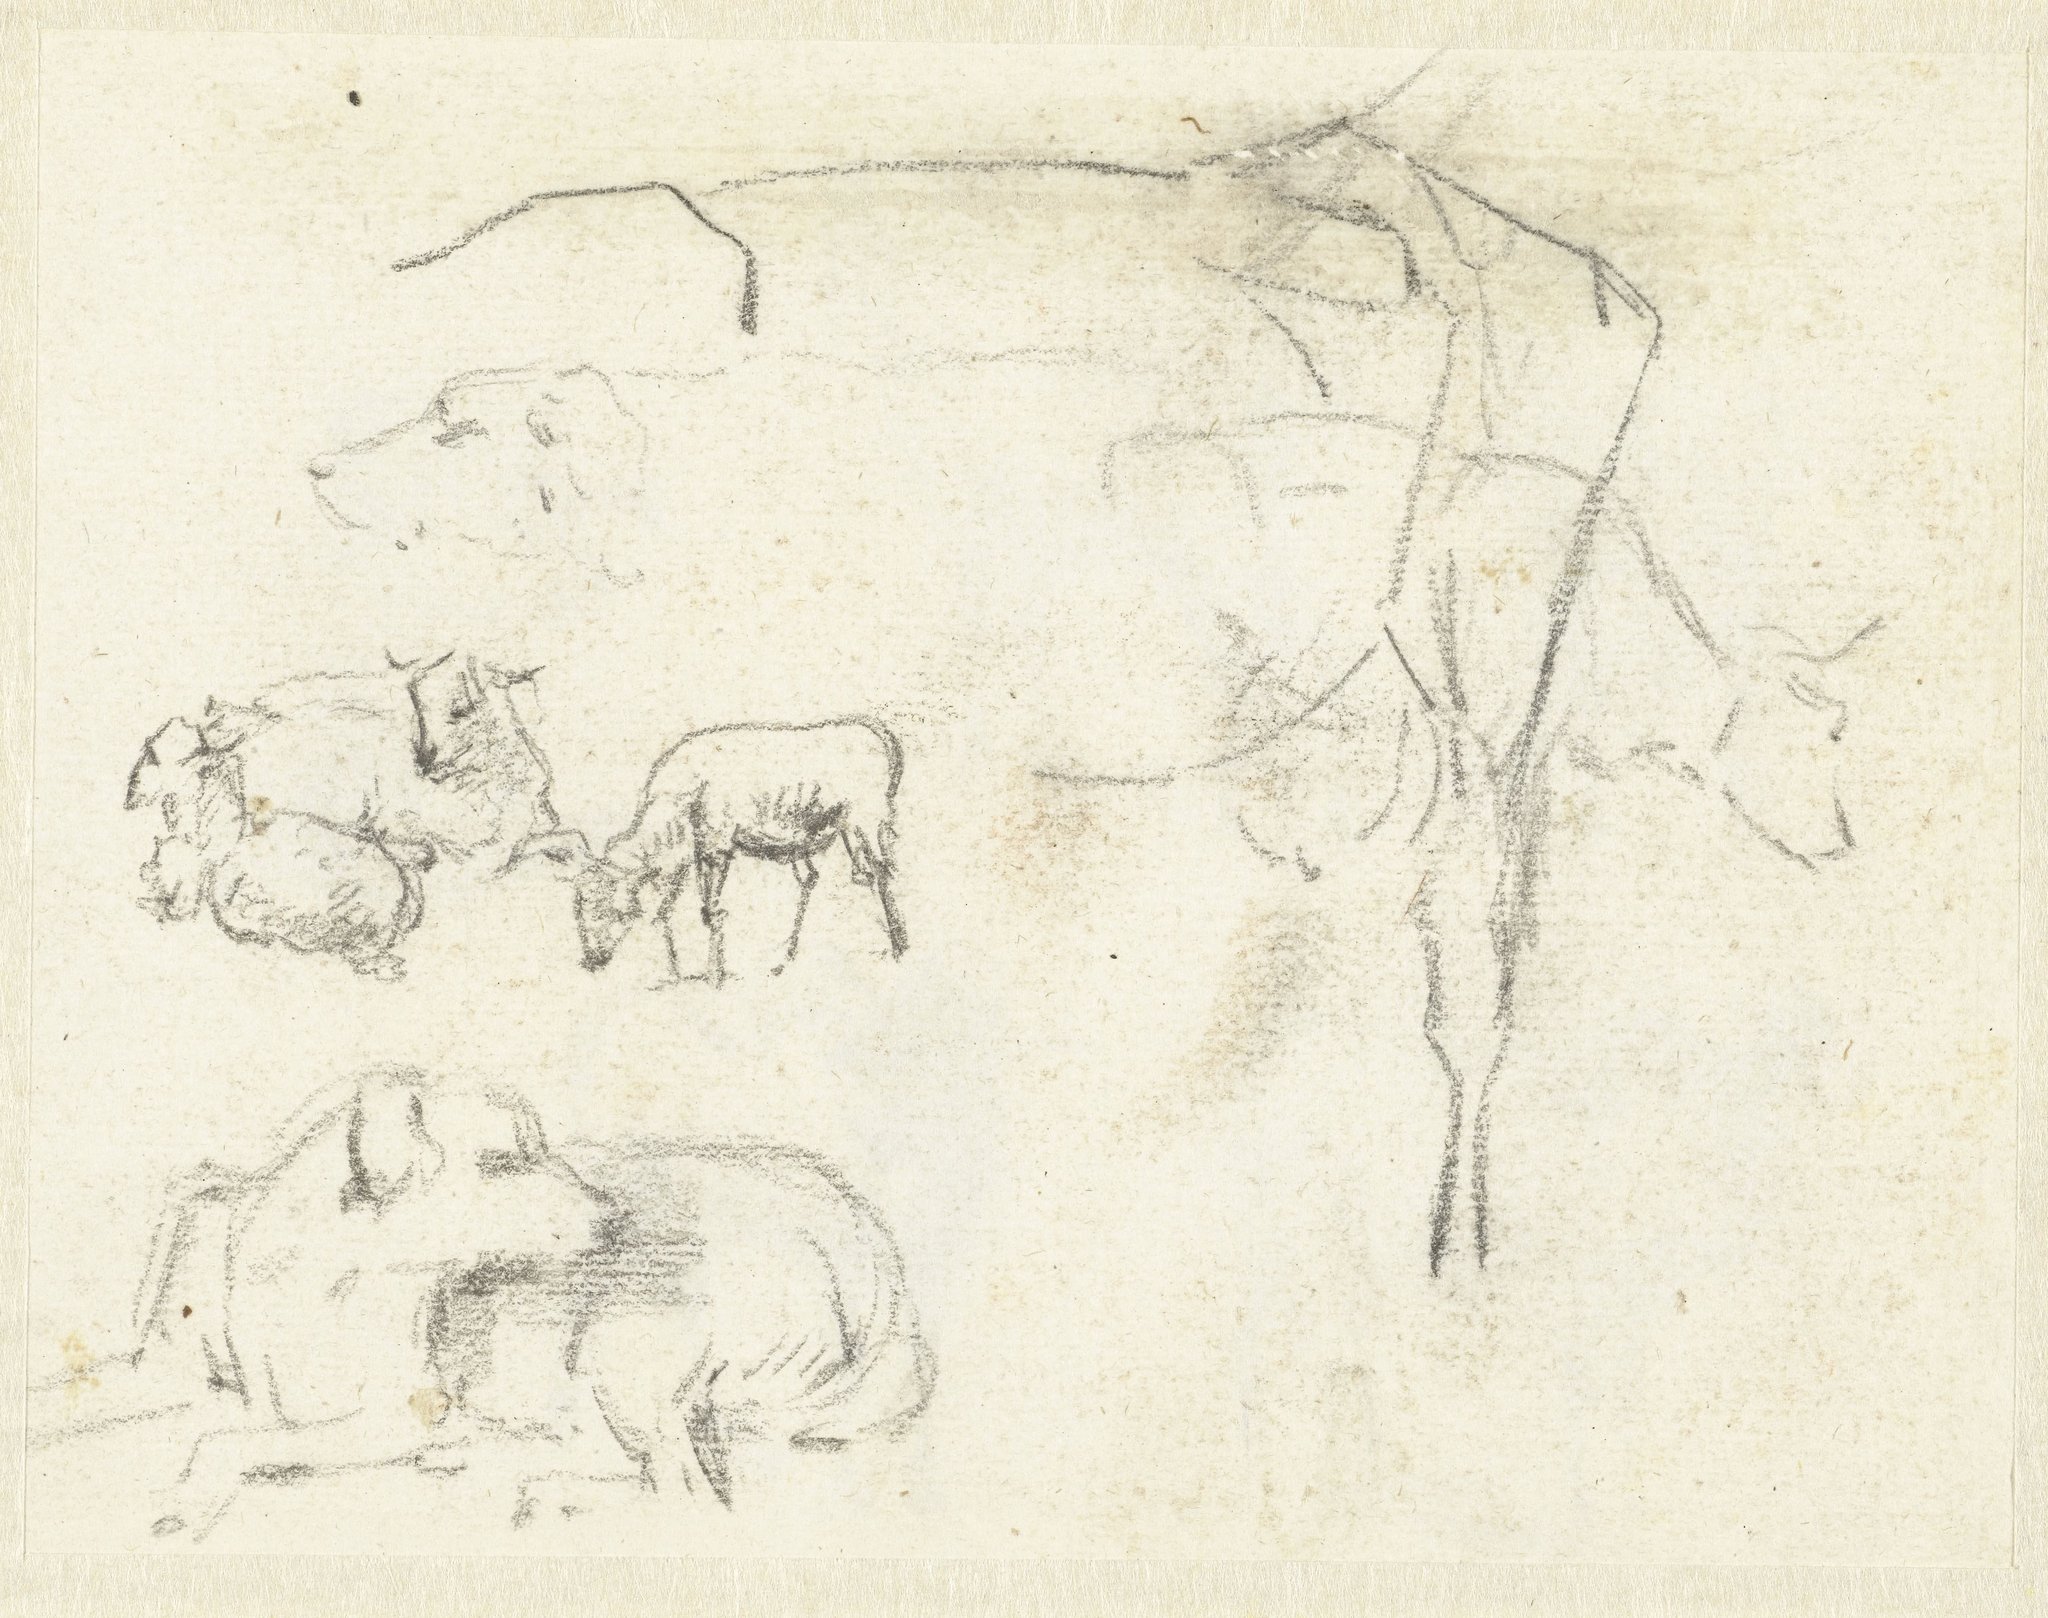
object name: drawing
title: Schetsblad met honden, schapen en een koe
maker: pieter gerardus van os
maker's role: draughtsman, painter, print maker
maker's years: 1776-1839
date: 1786-1839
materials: chalk, paper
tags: cow, sheep, dog